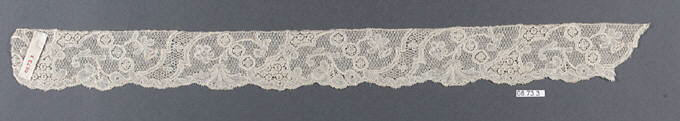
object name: piece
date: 1701-1733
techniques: lace